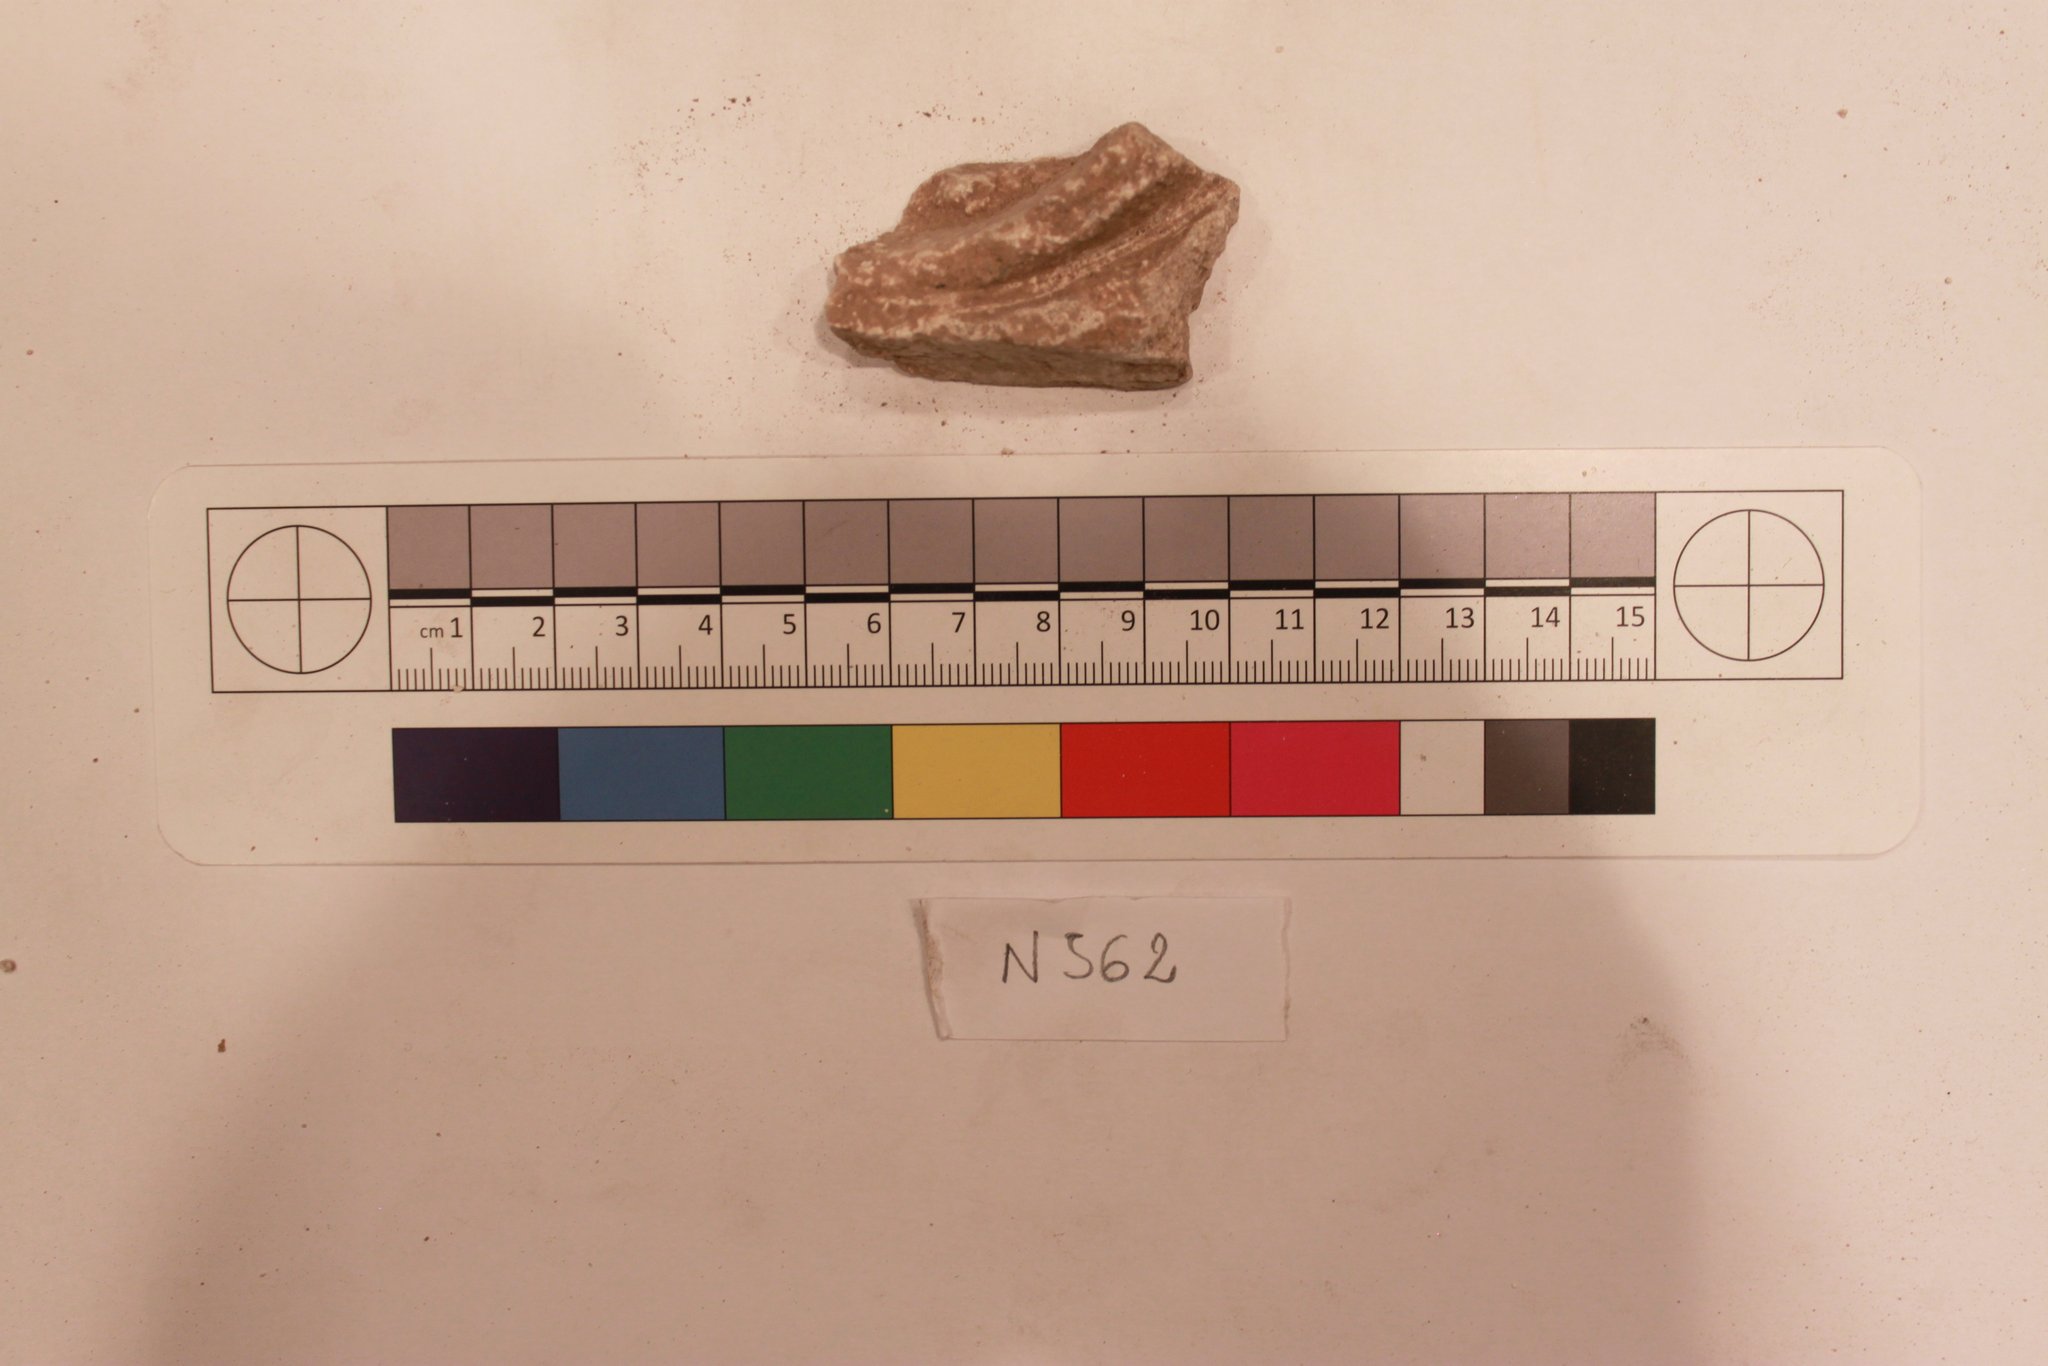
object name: fragment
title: Stucco Fragment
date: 701-1200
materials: plaster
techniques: carving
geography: iran